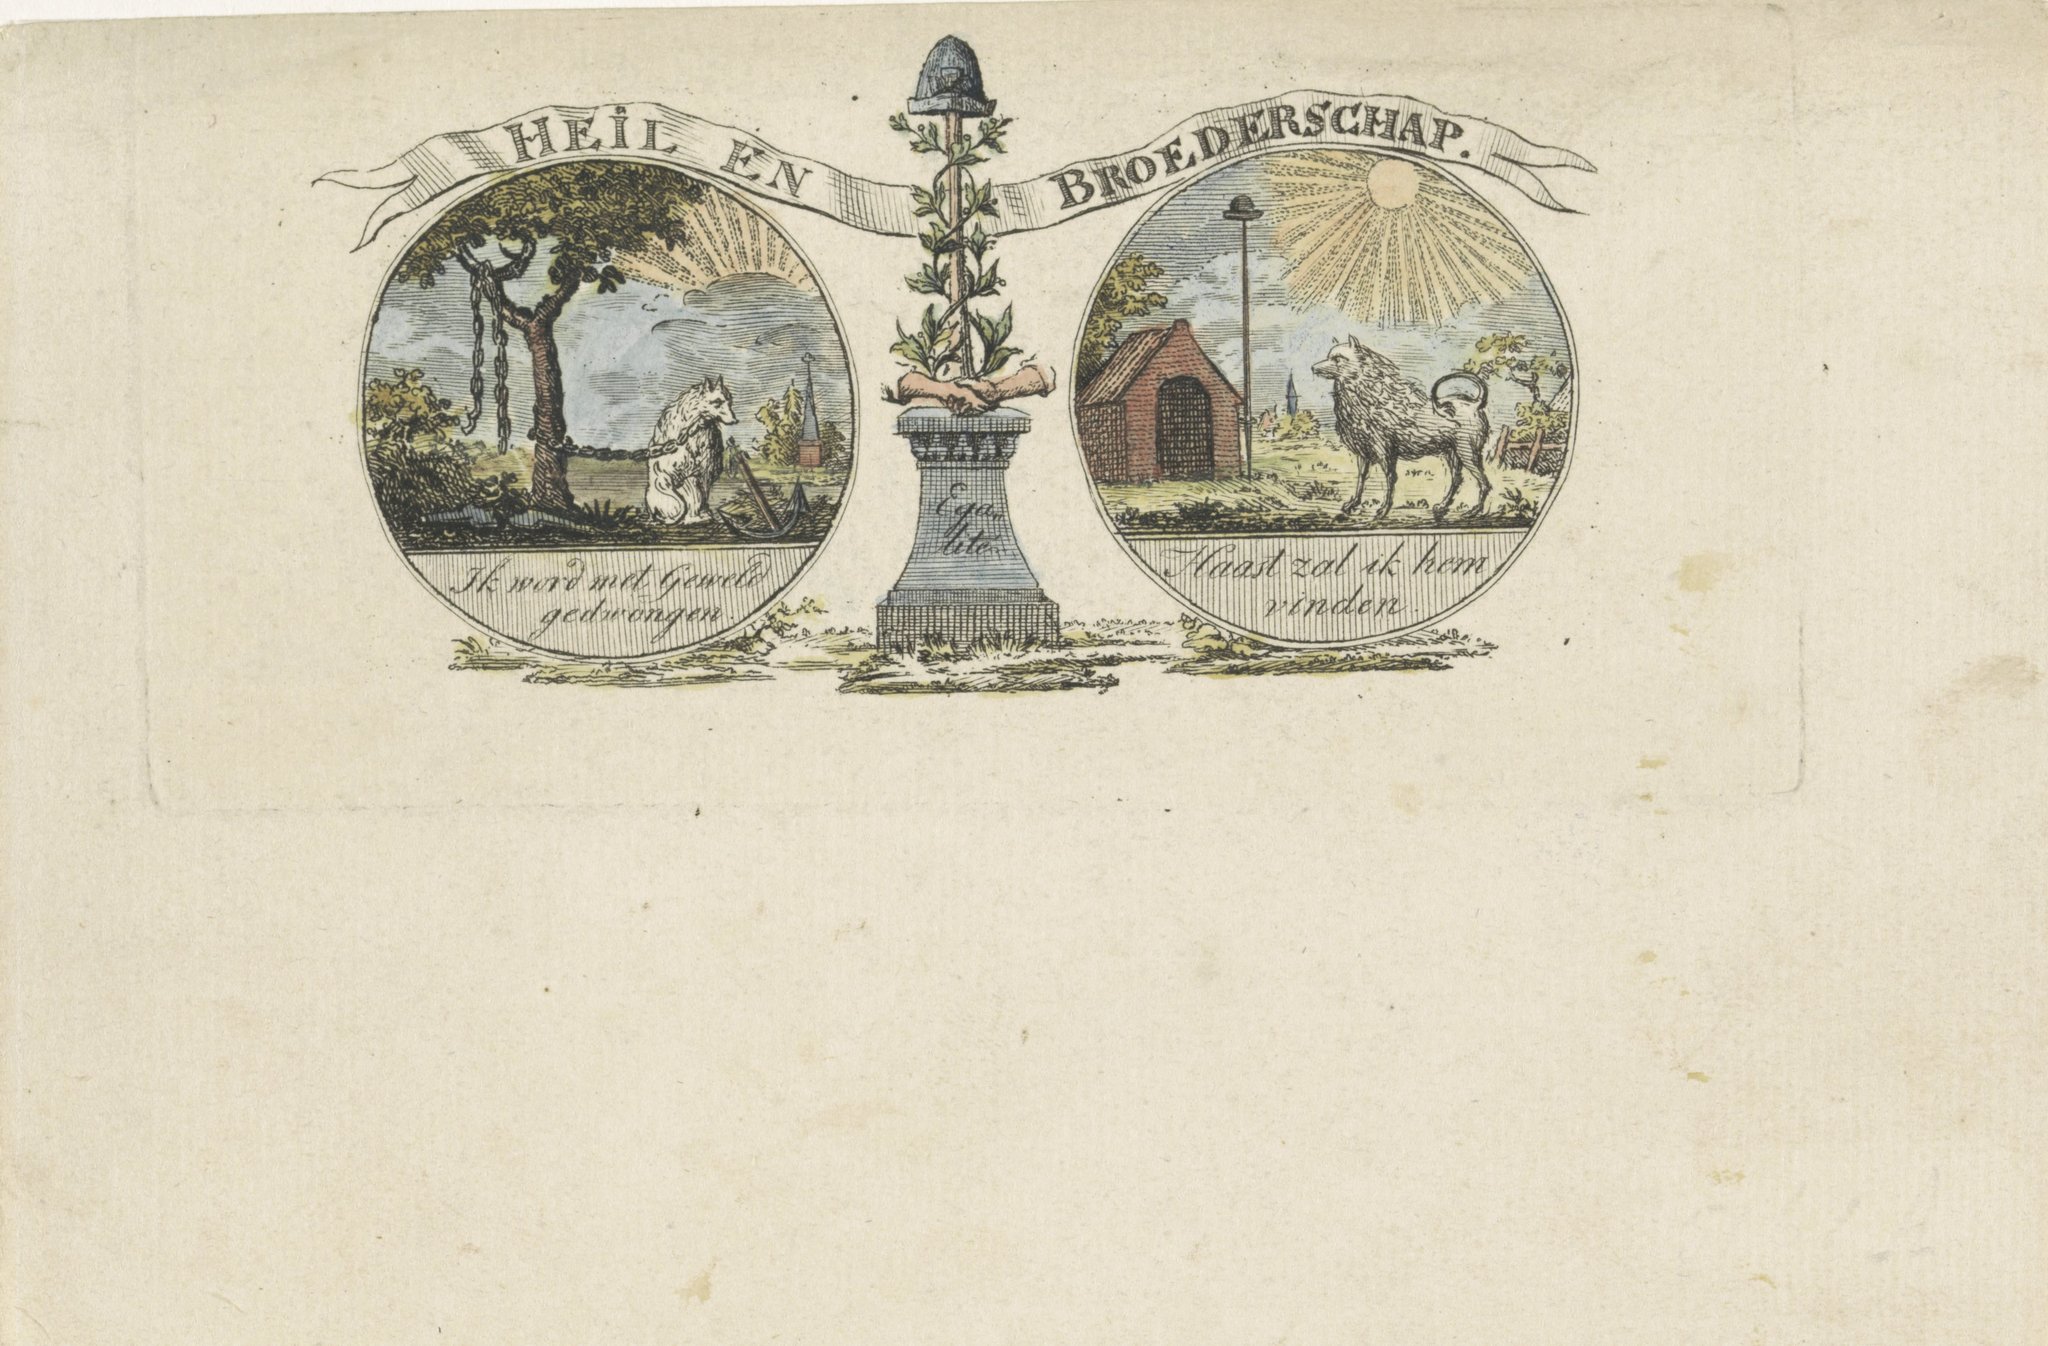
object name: print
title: Allegorie op de afwachtende houding van de Patriotten na 1787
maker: Anonymous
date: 1791-1792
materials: paper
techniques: engraving, etching, hand coloring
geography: northern netherlands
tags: fortitude, 'fortitudo' ~ one of the four cardinal virtues, hope, 'spes'; 'speranza divina e certa' (ripa) ~ one of the three theological virtues, dog, patriots (1780-1795)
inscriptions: collector's mark: Lugt 2228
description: Allegorie op de afwachtende houding van de Patriotten of Kezen na 1787, ca. 1791-1792. In cirkel links: een keeshond met ketting aan een boom geklonken. Met onderschrift: ik word met geweld gedwongen. In cirkel rechts: een keeshond staand voor een hondenhok en paal met vrijheidshoed. Met onderschrirft: Haast zal ik hem vinden. Tussen de beide cirkels vrijheidsboom op sokkel met titel Egalité.